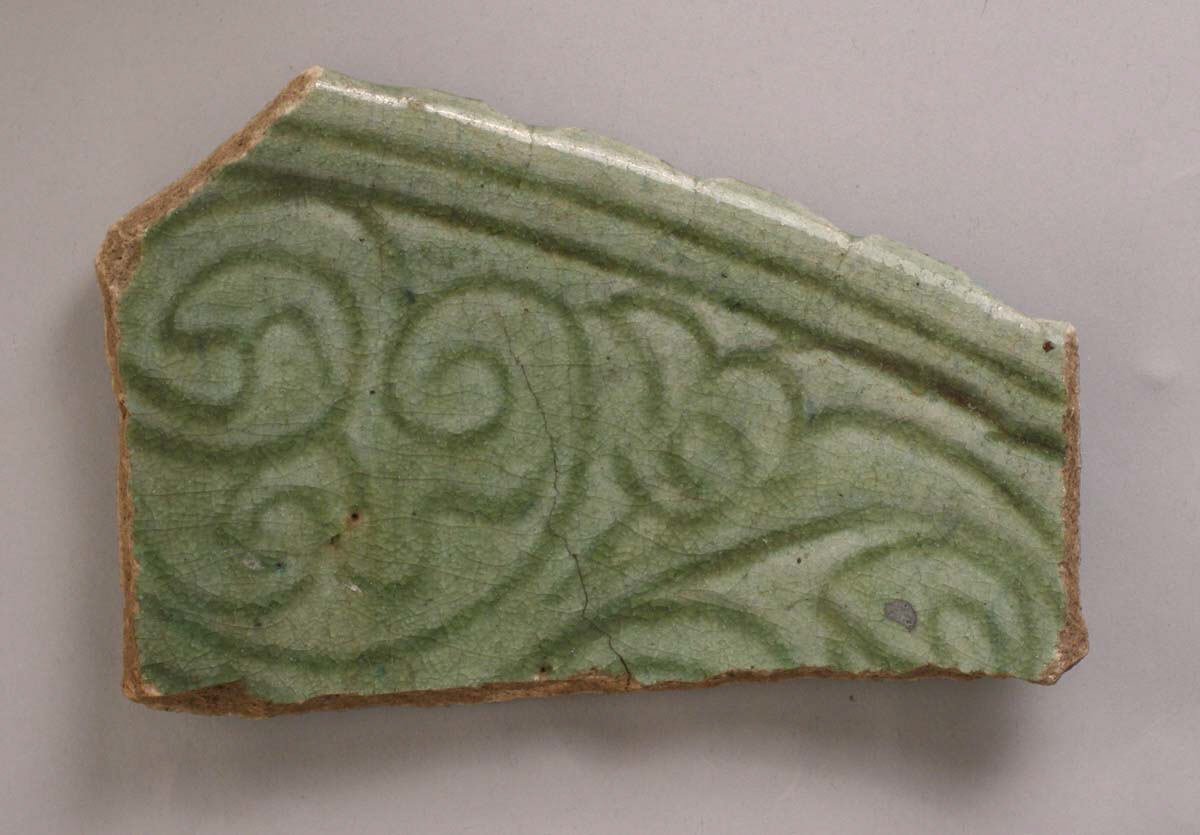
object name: ceramic fragment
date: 1201-1400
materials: glaze, stonepaste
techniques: incising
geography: egypt